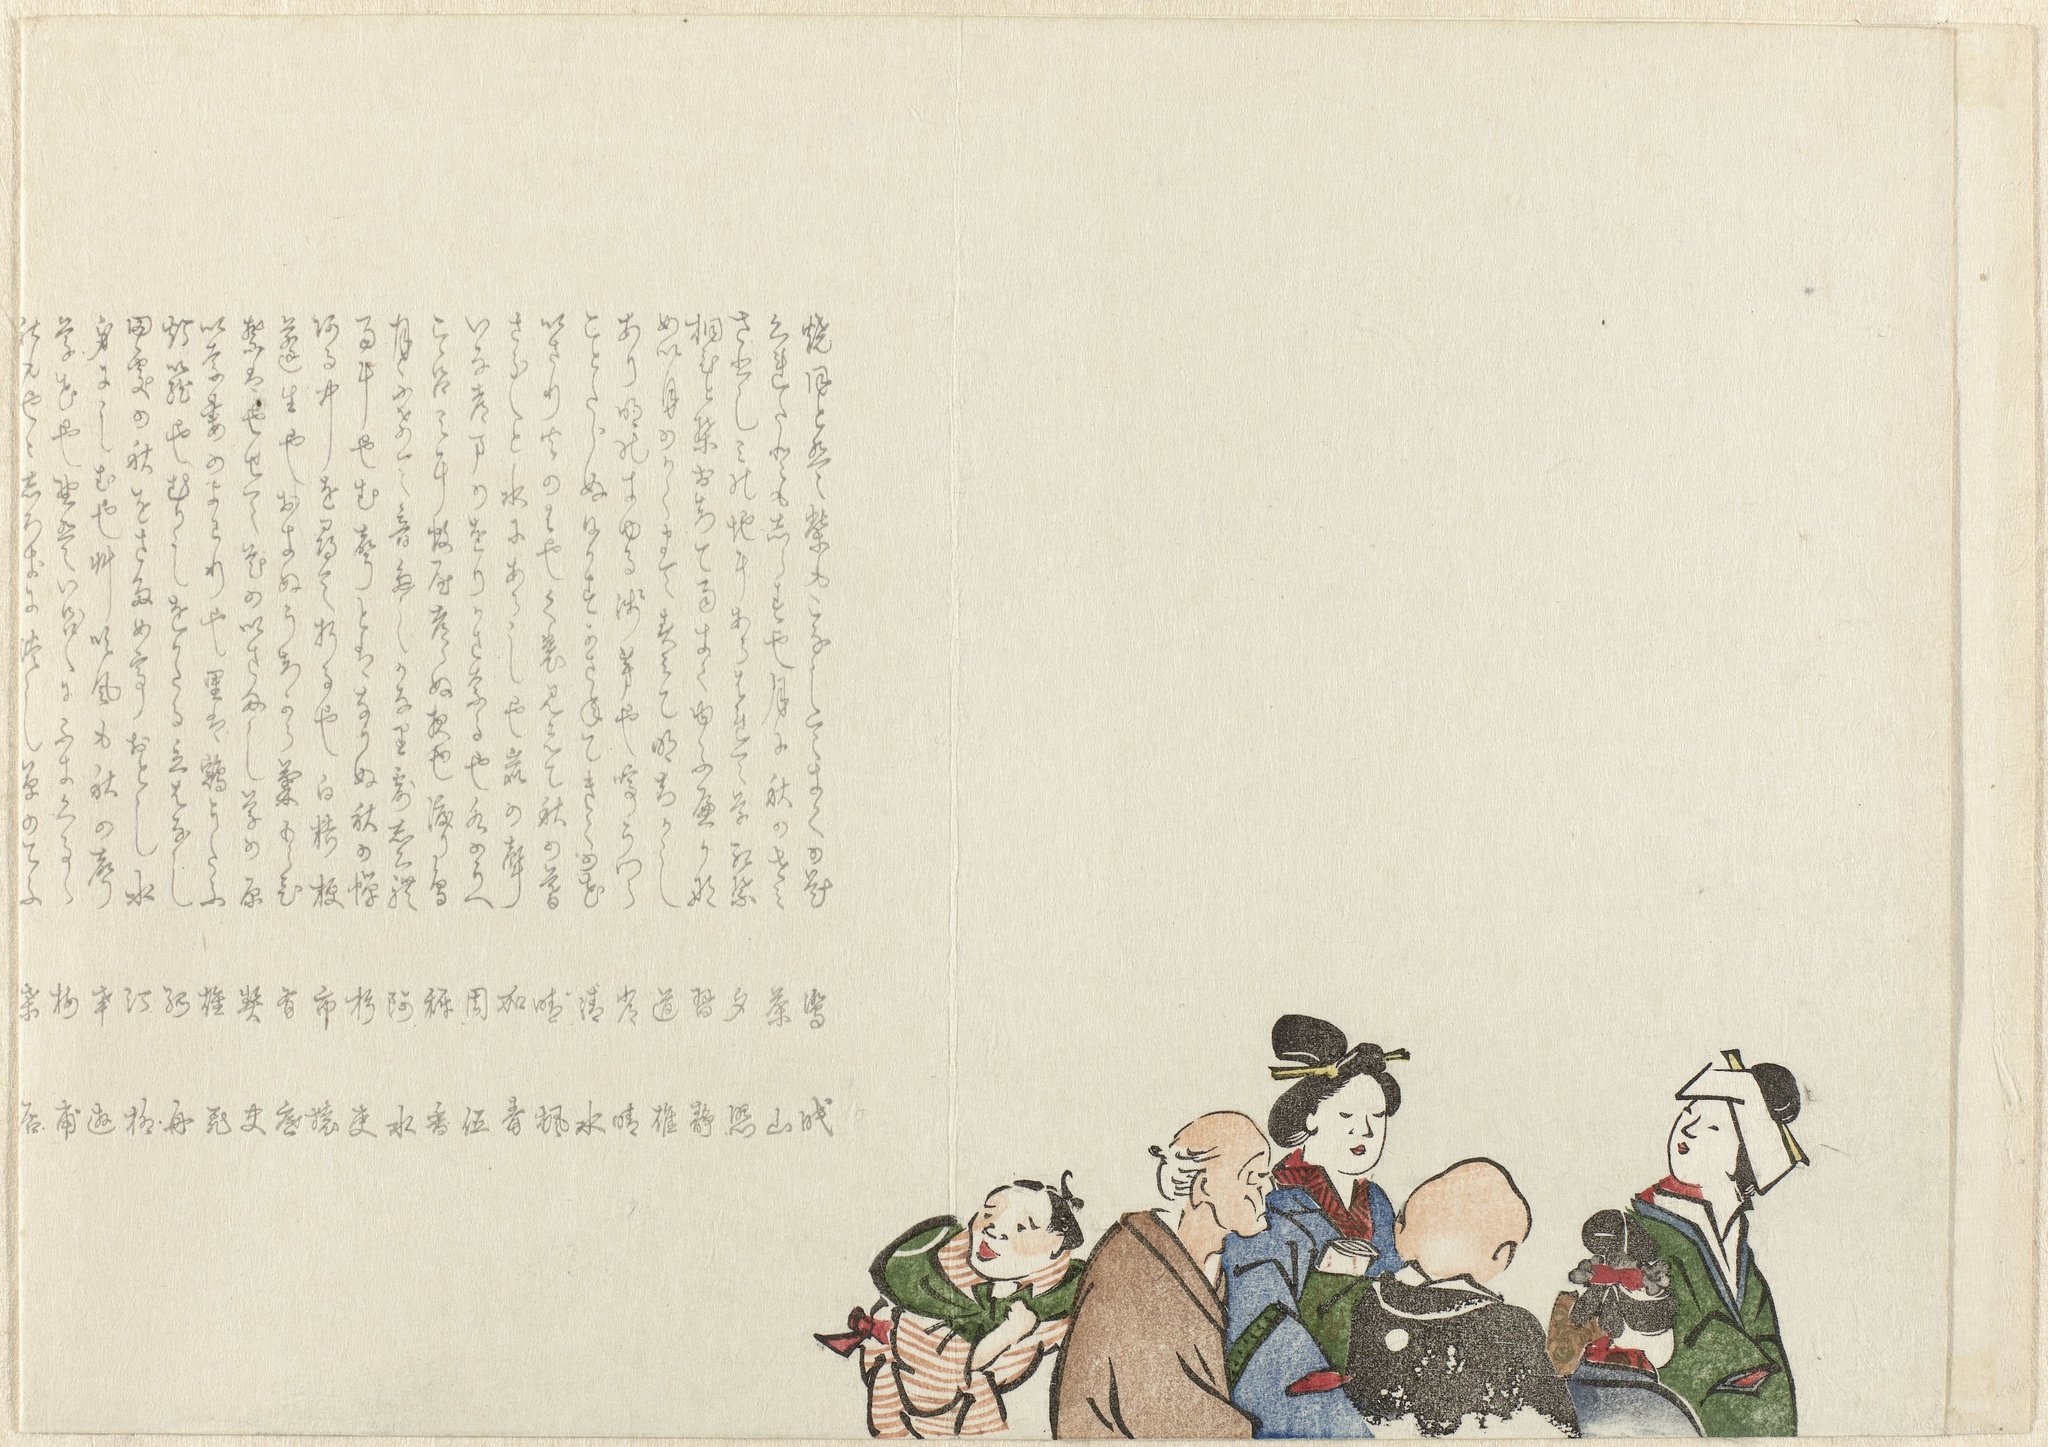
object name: surimono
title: Groep mensen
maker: shito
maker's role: houtsnijder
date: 1890-1900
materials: paper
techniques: woodcut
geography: japan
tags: family group, especially parents with their child(ren), japanese, oriental ideographic script (chinese, korean, japanese)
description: Een surimono is een luxe uitgevoerde prent waarop beeld met één of meerdere gedichten gecombineerd is. Bij het drukken van een surimono werd vaak gebruik gemaakt van dikker papier, blinddruk en metaal pigmenten, zoals koper- en zilverpoeder. De prenten werden vaak in opdracht van dichters gemaakt en als exclusief geschenk aan vrienden en relaties gegeven.